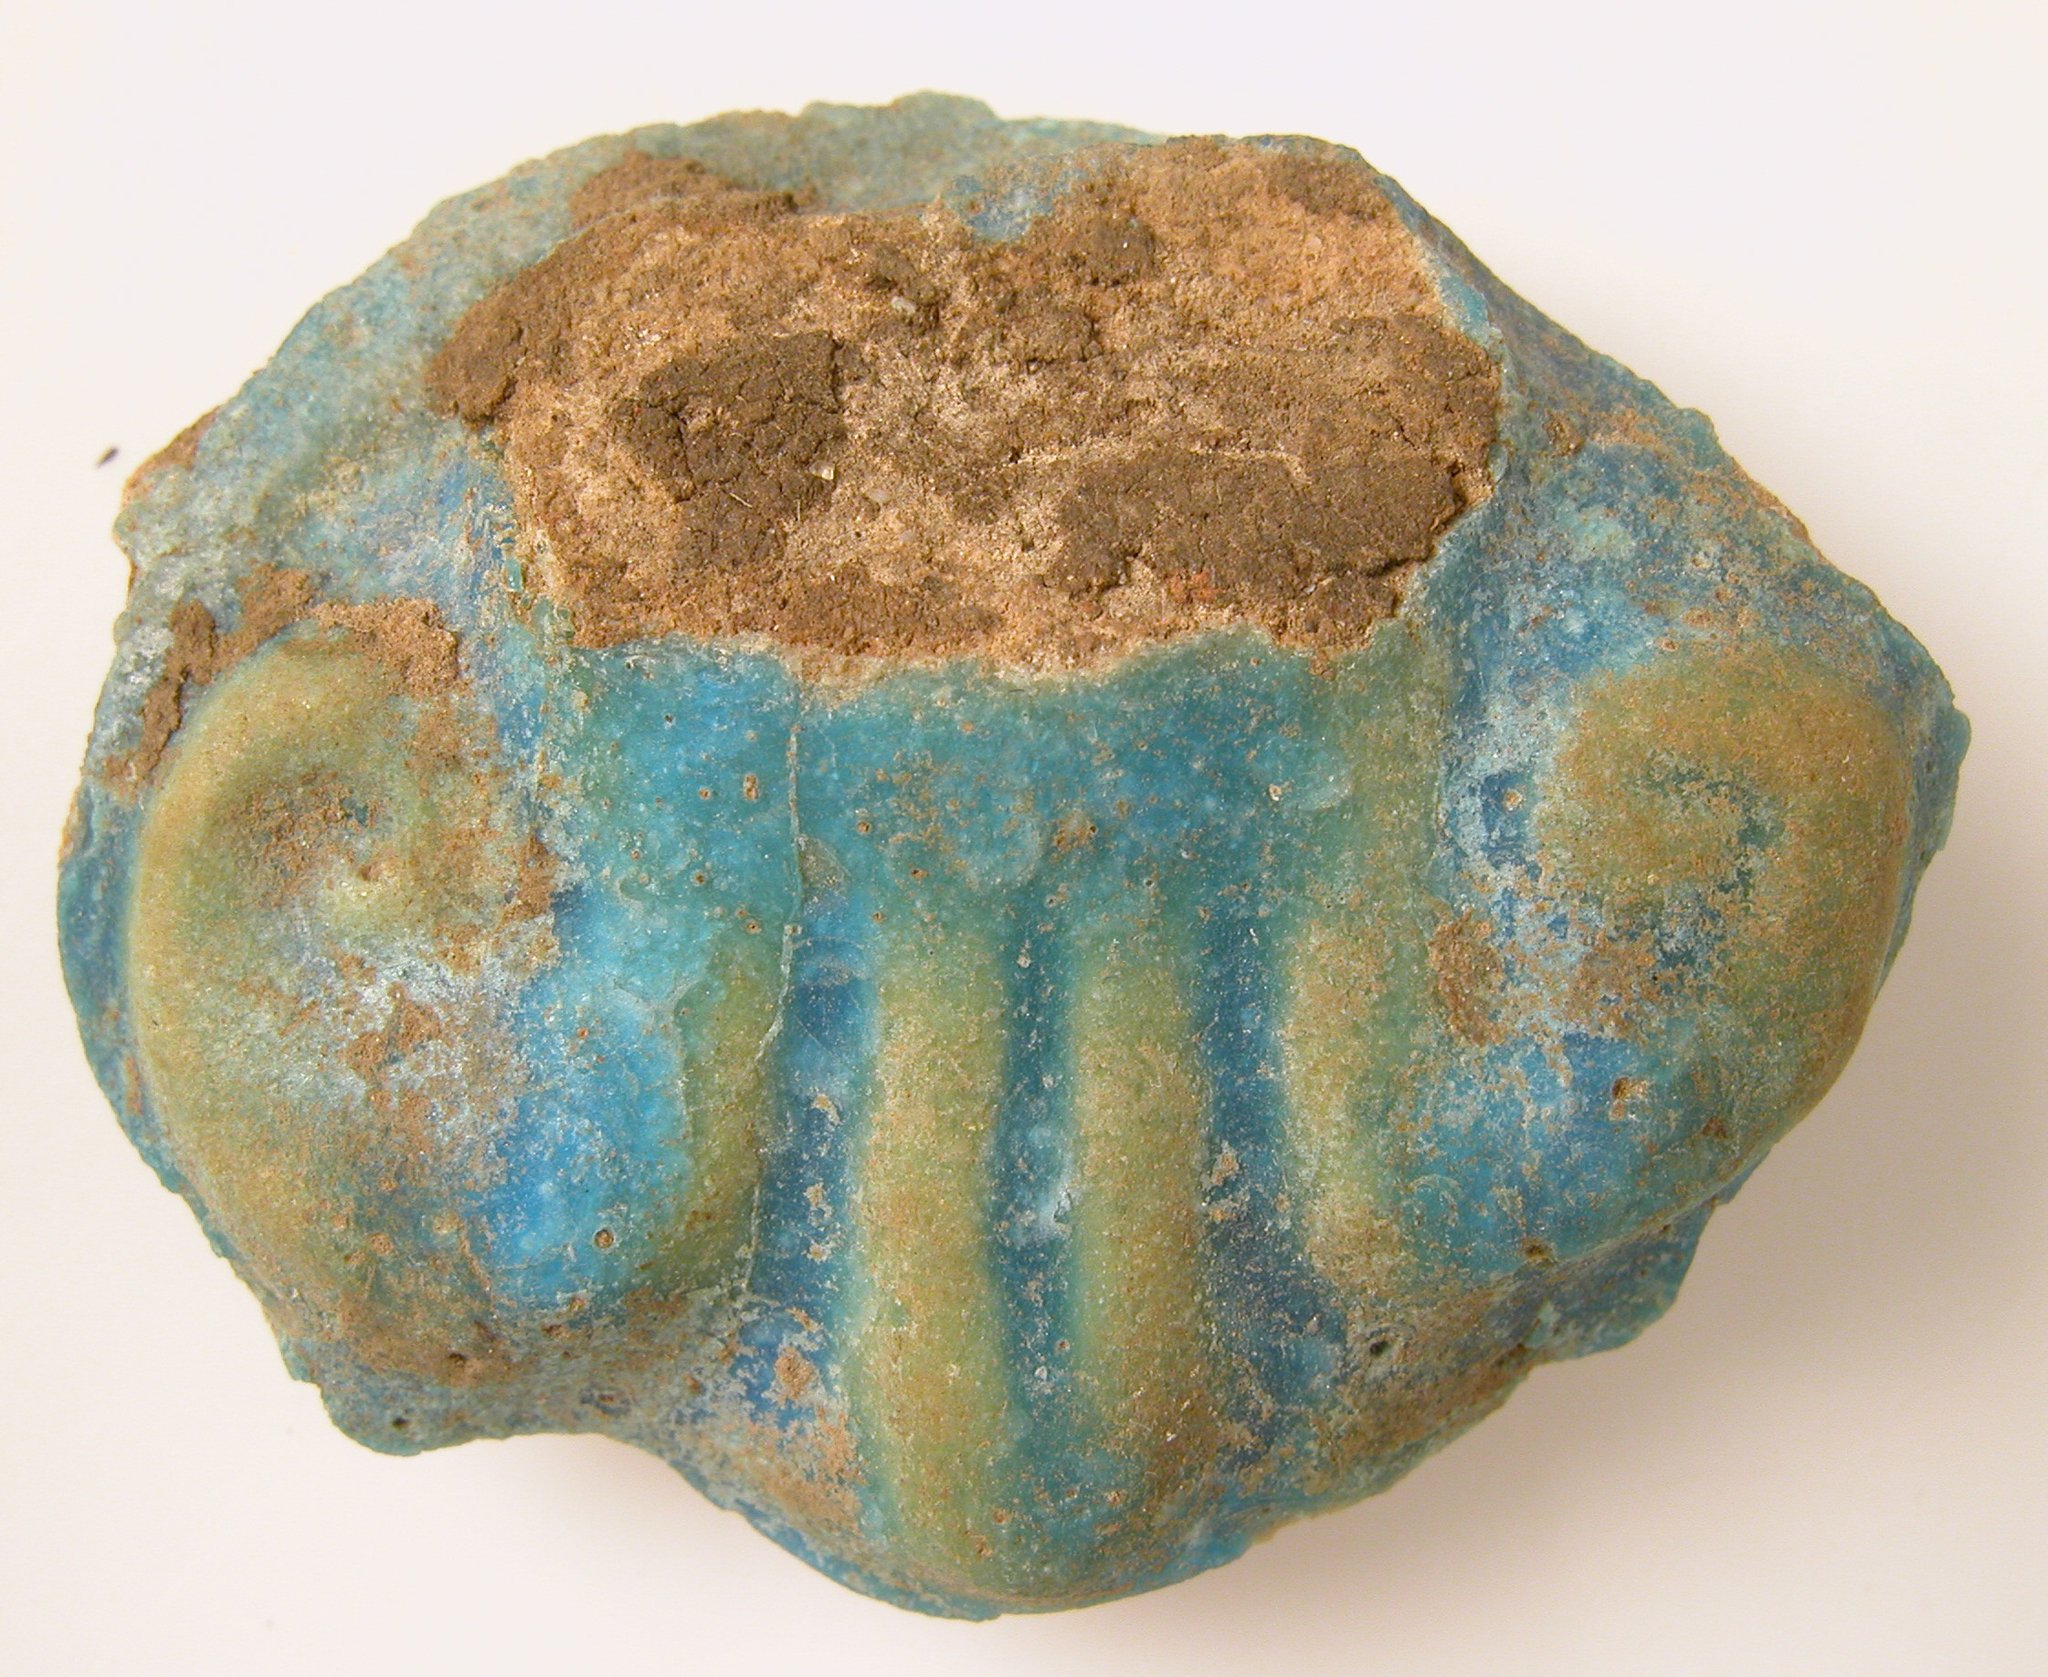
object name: fragment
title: Pottery Fragment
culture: coptic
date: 301-700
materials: earthenware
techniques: glazing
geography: egypt